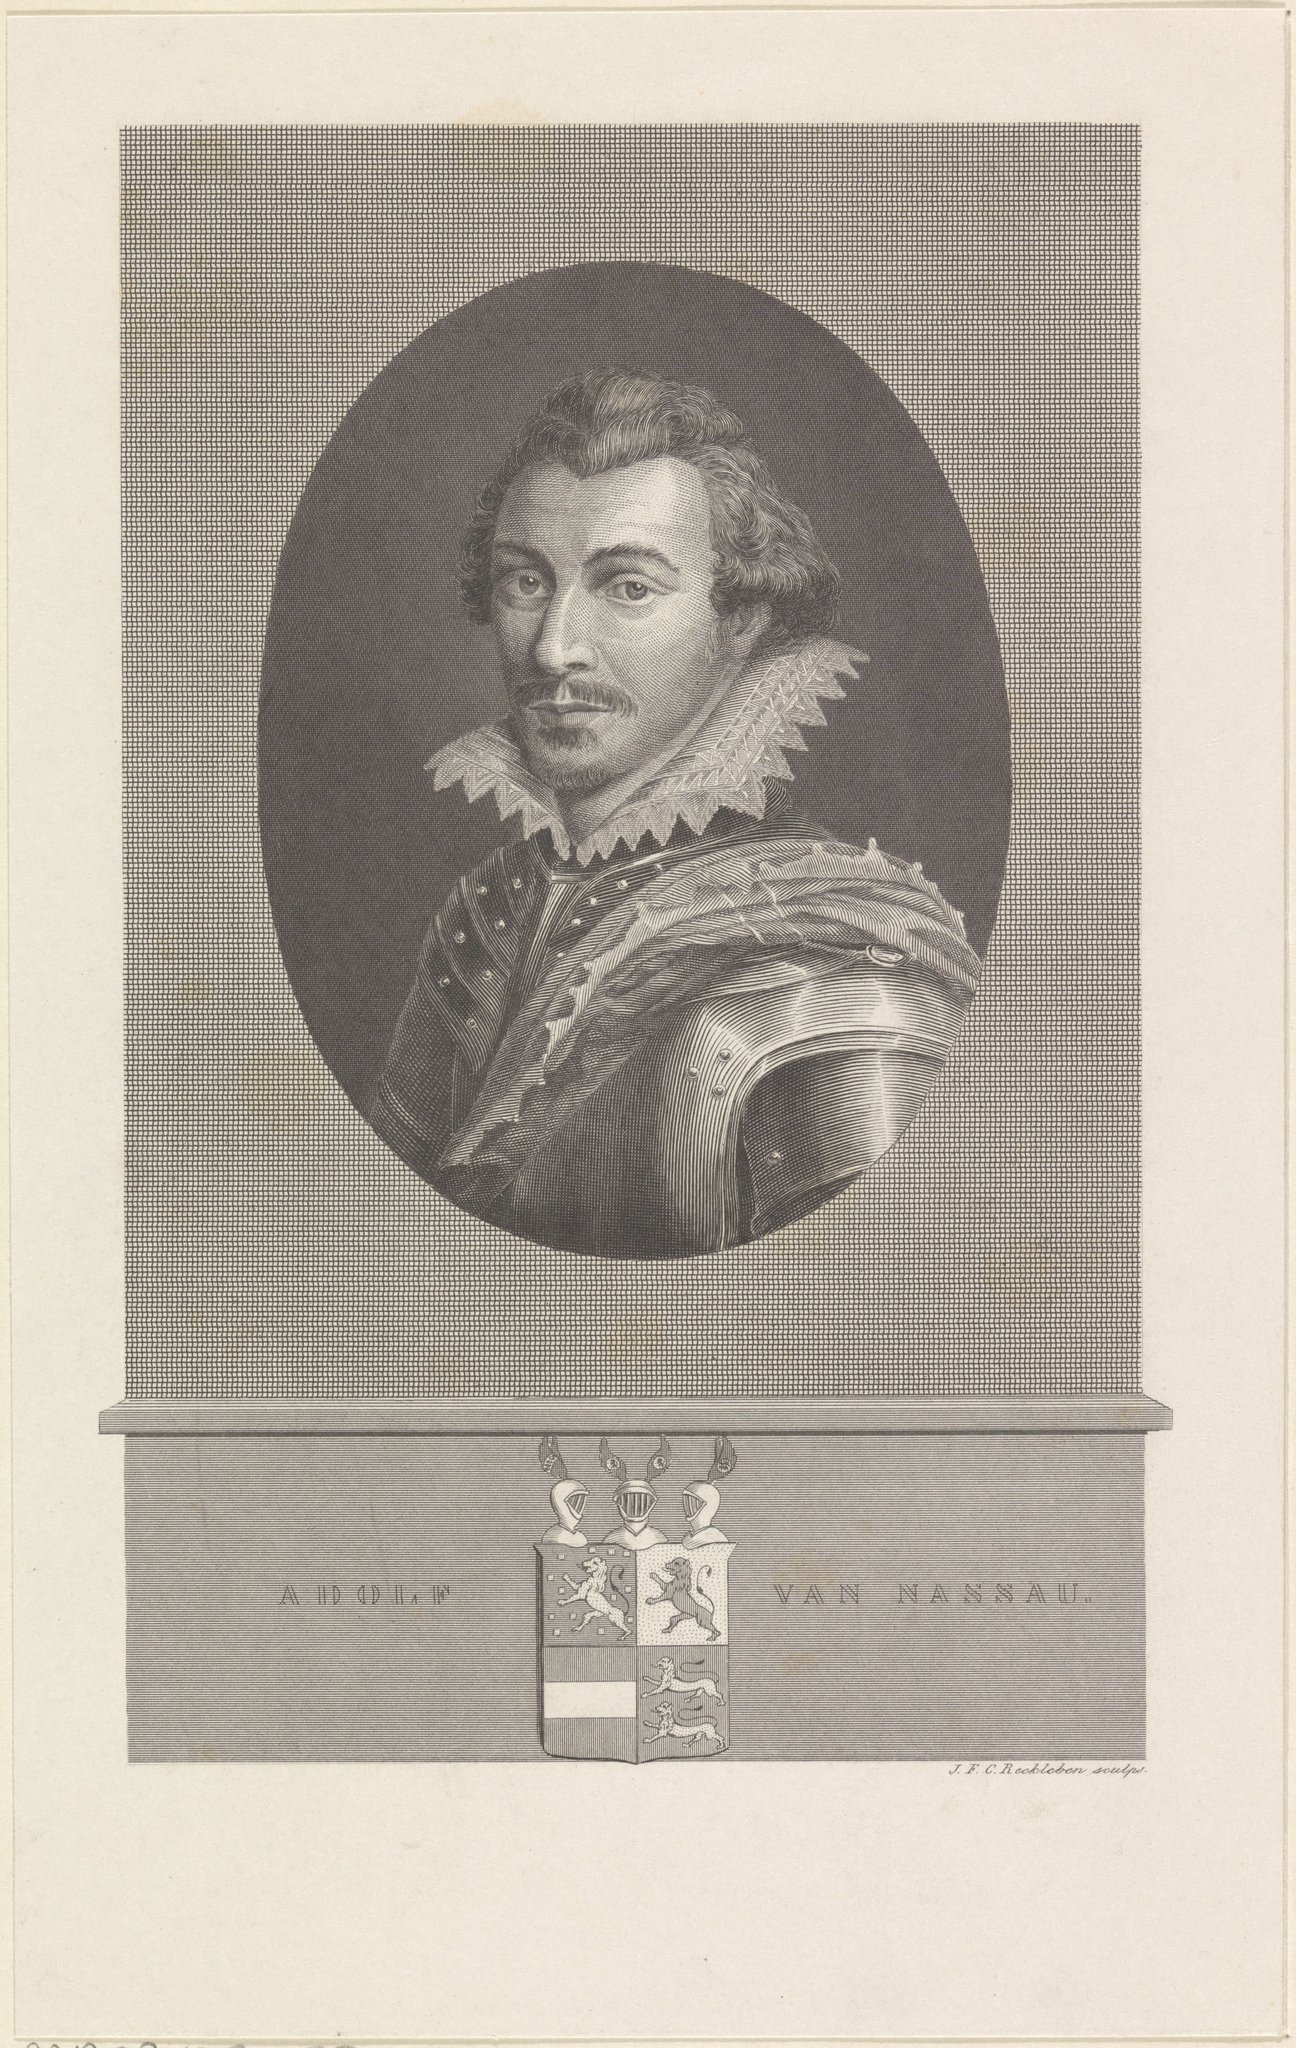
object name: print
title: Portret van Adolf, graaf van Nassau-Siegen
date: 1840-1884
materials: paper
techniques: engraving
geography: amsterdam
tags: earl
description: De hier vermelde titel verwijst naar de hoogst verkregen titel van de geportretteerde, niet per se naar de titel die de geportretteerde op deze voorstelling draagt. Prent uit: Arend, Johannes Pieter. Algemeene geschiedenis des vaderlands van de vroegste tijden tot op heden. Amsterdam: J.F. Schleijer, 1840-1884.